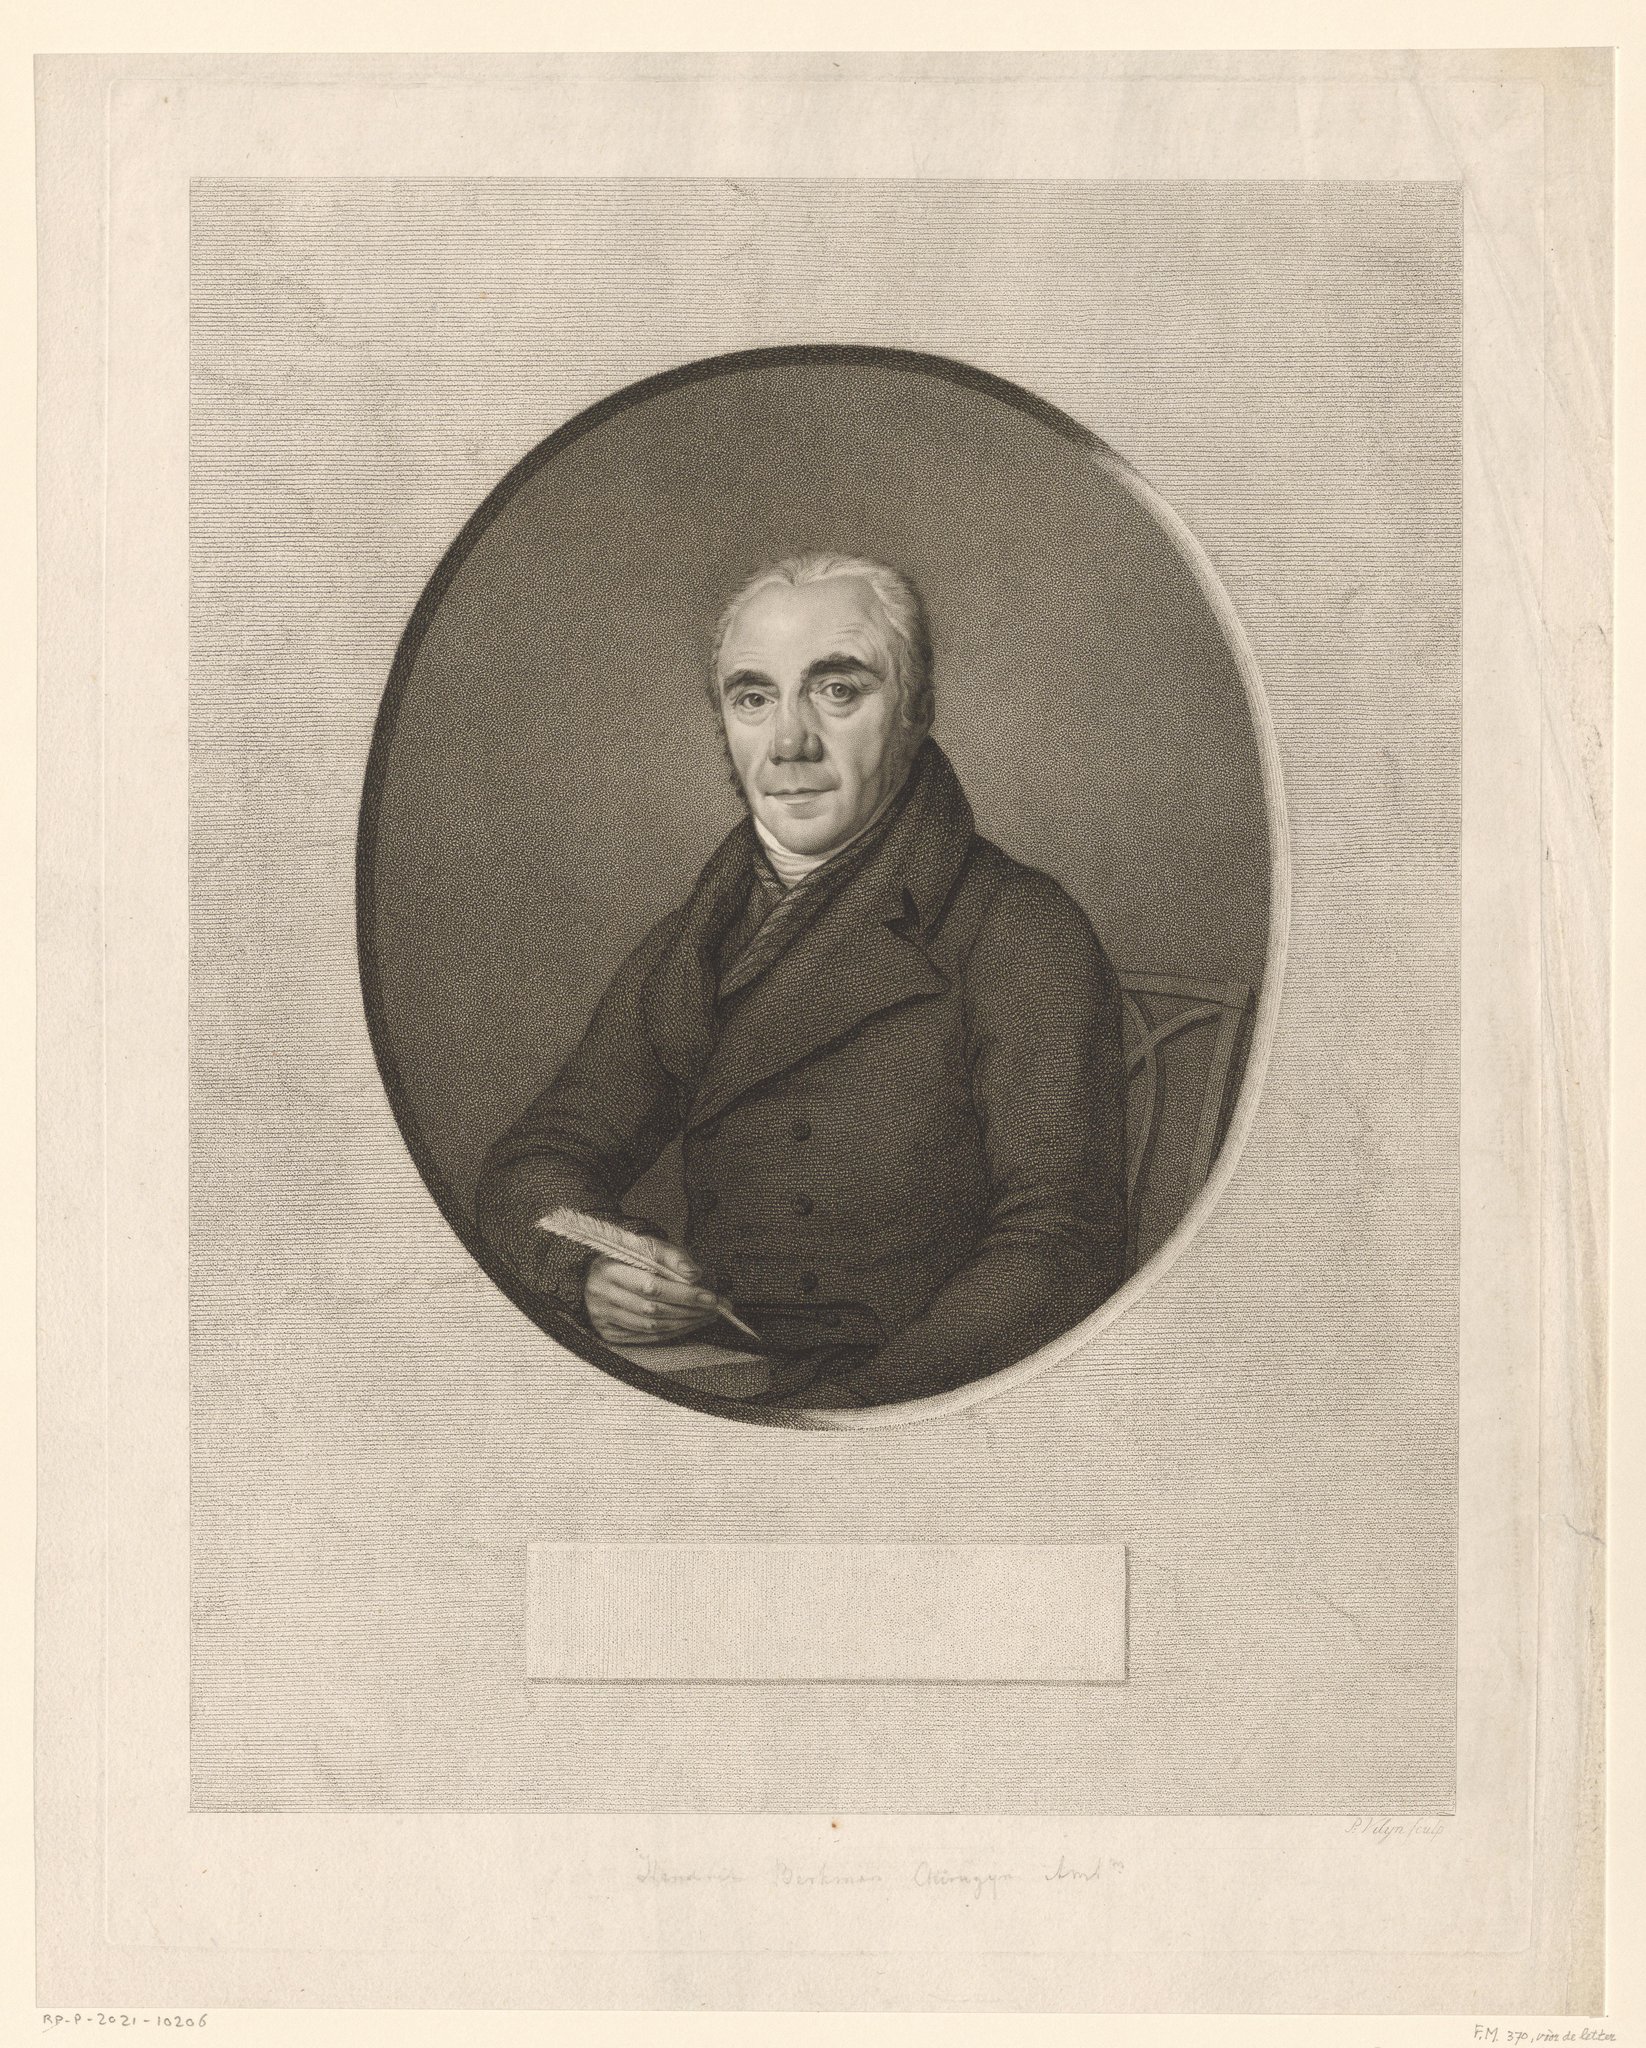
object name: print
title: Portret van Hendrik Berkman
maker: philippus velijn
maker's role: print maker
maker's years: 1787-1836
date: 1797-1836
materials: paper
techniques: engraving, etching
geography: netherlands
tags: quill, historical persons, physician, doctor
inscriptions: collector's mark: Lugt 2228